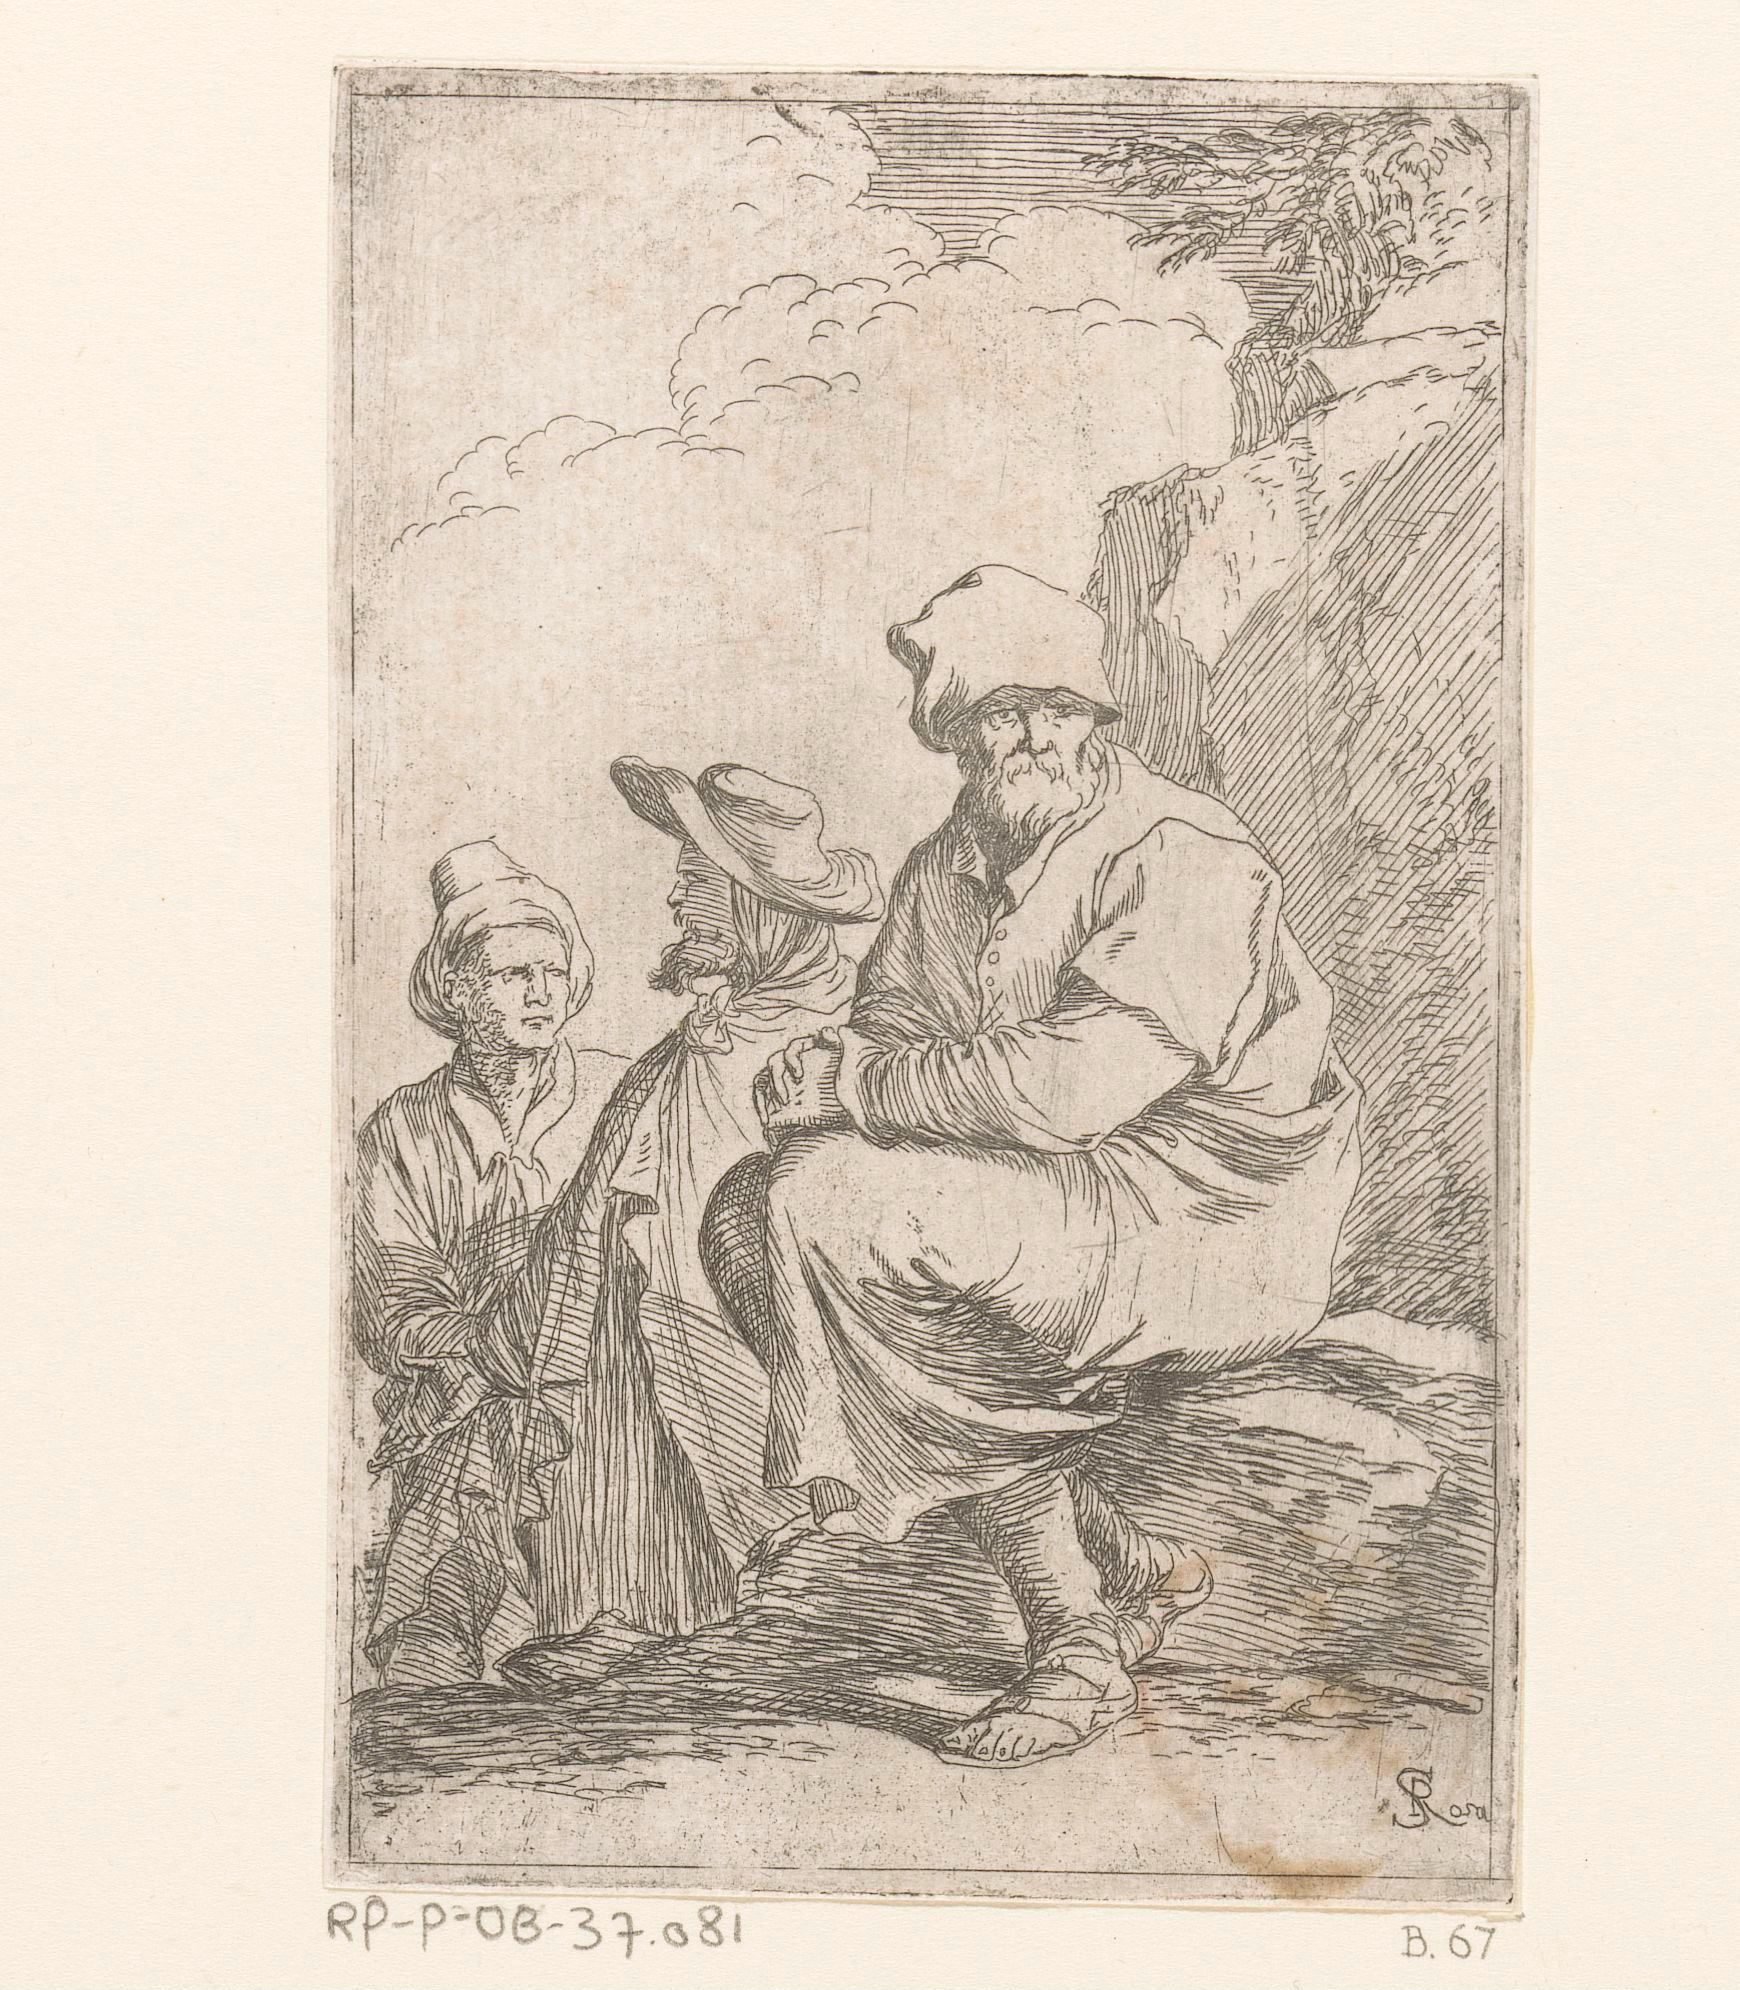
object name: print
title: Kleine figuren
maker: salvator rosa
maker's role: draughtsman, painter, print maker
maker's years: 1615-1673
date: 1656-1657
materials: paper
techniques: drypoint, etching, intaglio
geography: italy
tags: old man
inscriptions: collector's mark: Lugt 240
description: Deze prent maakt deel uit van de serie 'Figurine', bestaande uit een titelprent en 80 prenten van klein formaat met voorstellingen van mannelijke en vrouwelijke figuren. Rosa produceerde de serie waarschijnlijk gedurende de jaren 1656 en 1657.